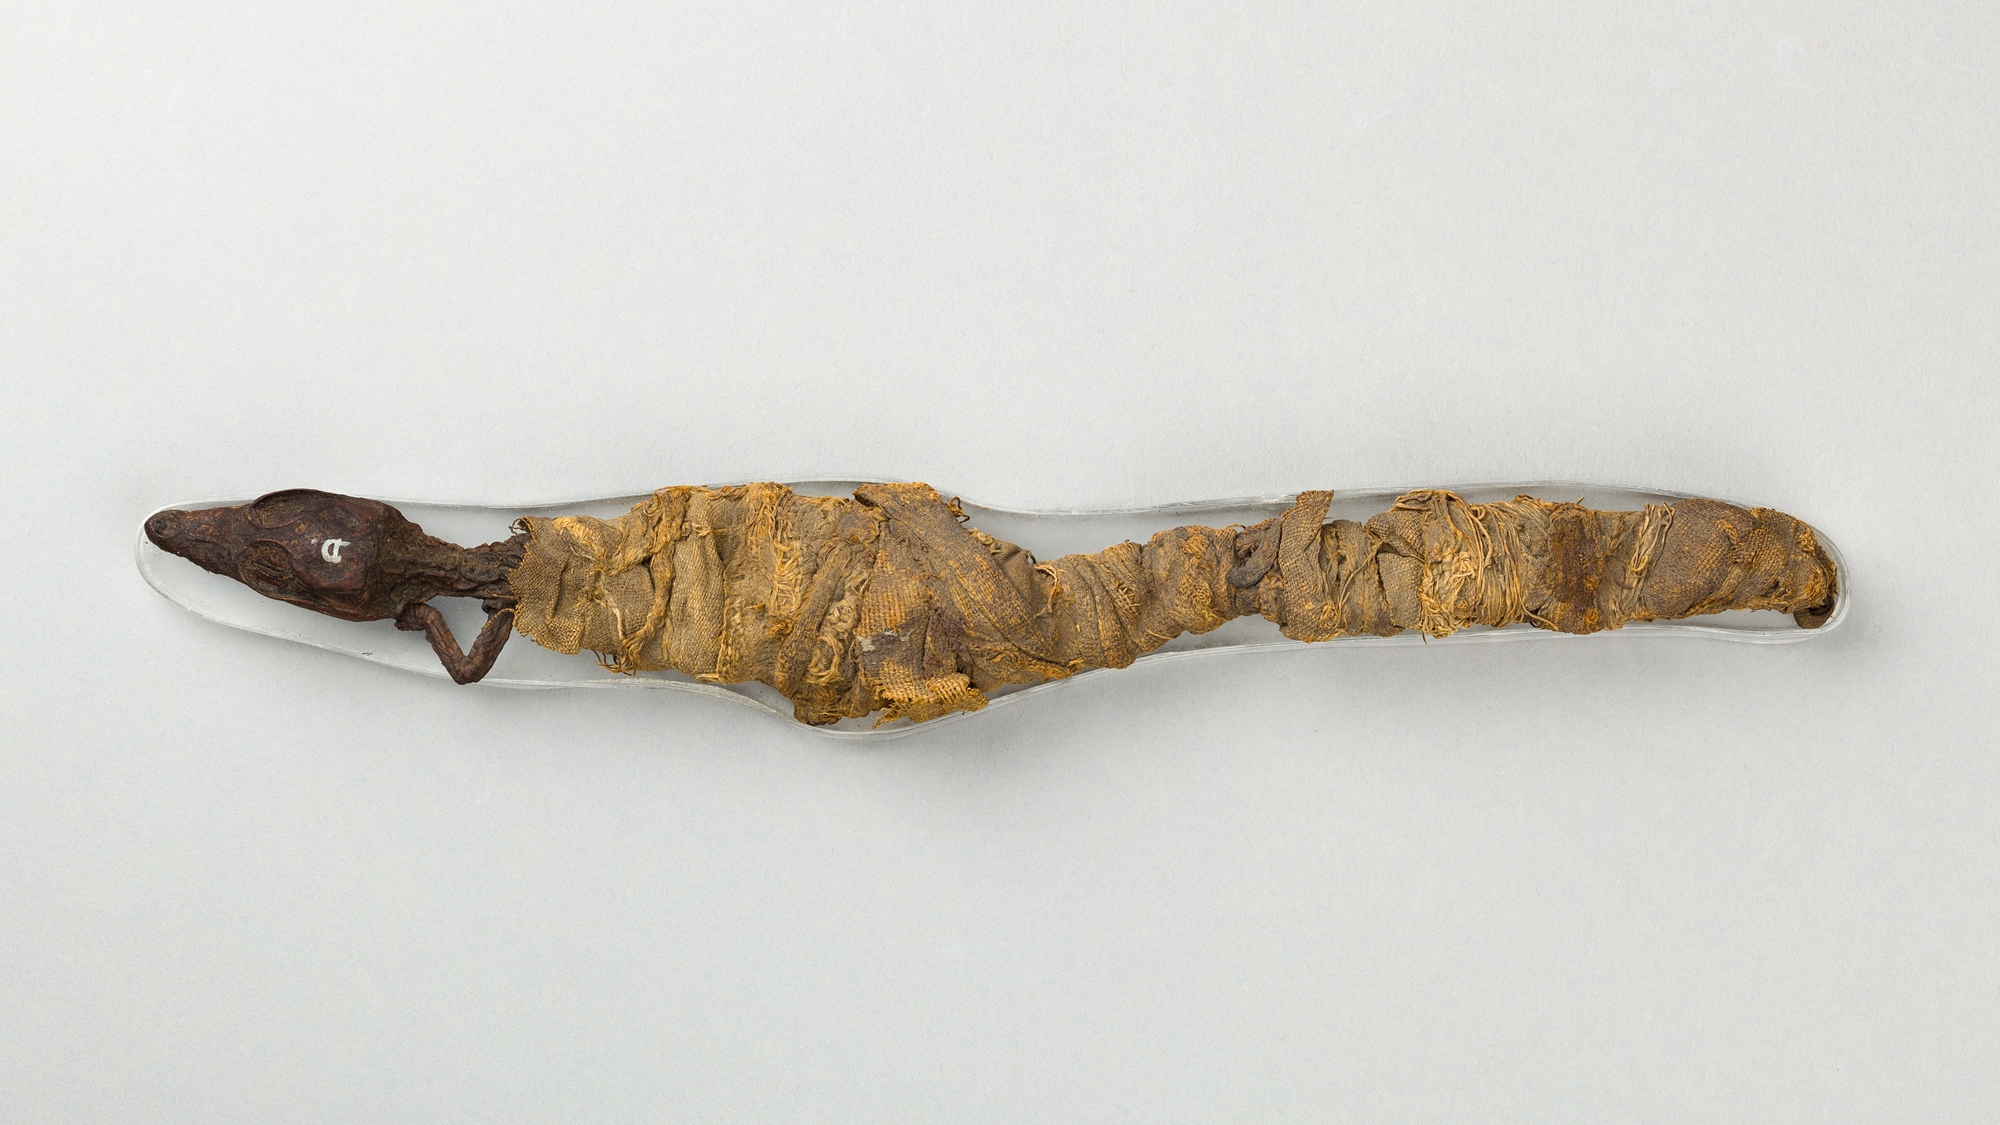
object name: mummy, crocodile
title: Sacred animal mummy of crocodile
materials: linen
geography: middle egypt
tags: crocodiles,mummies